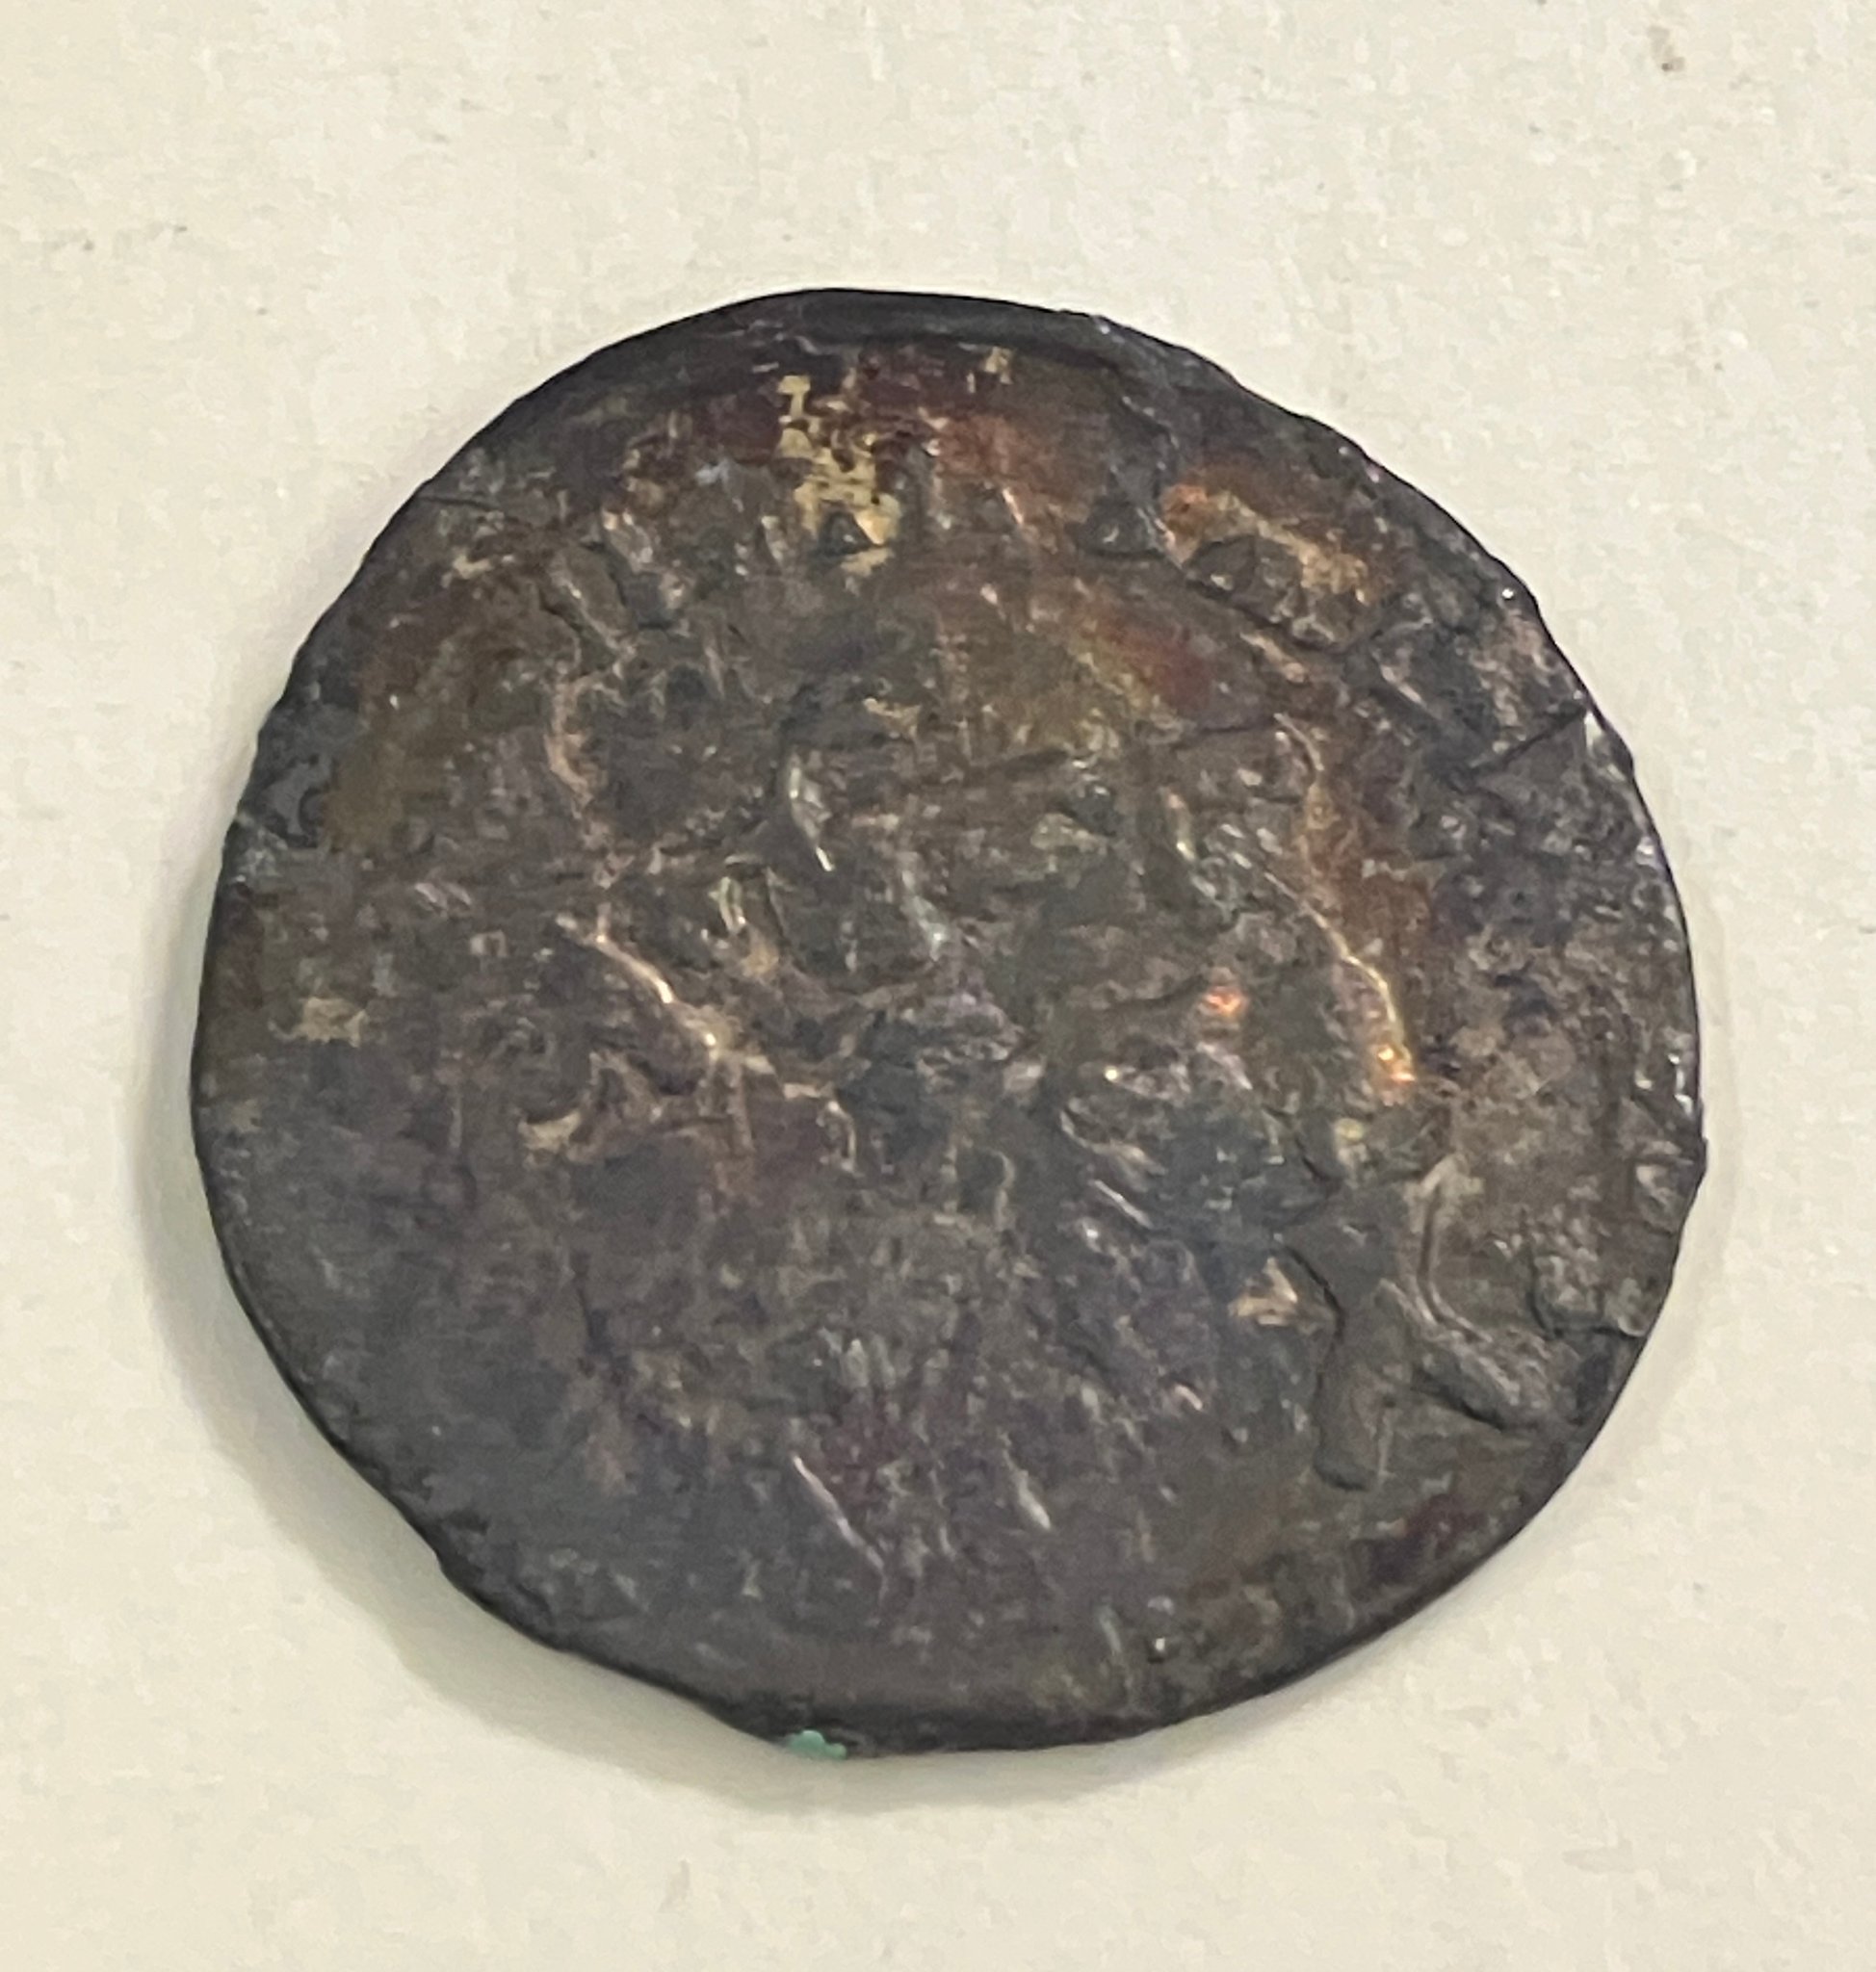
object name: coin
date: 401-1400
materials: silver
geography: iran